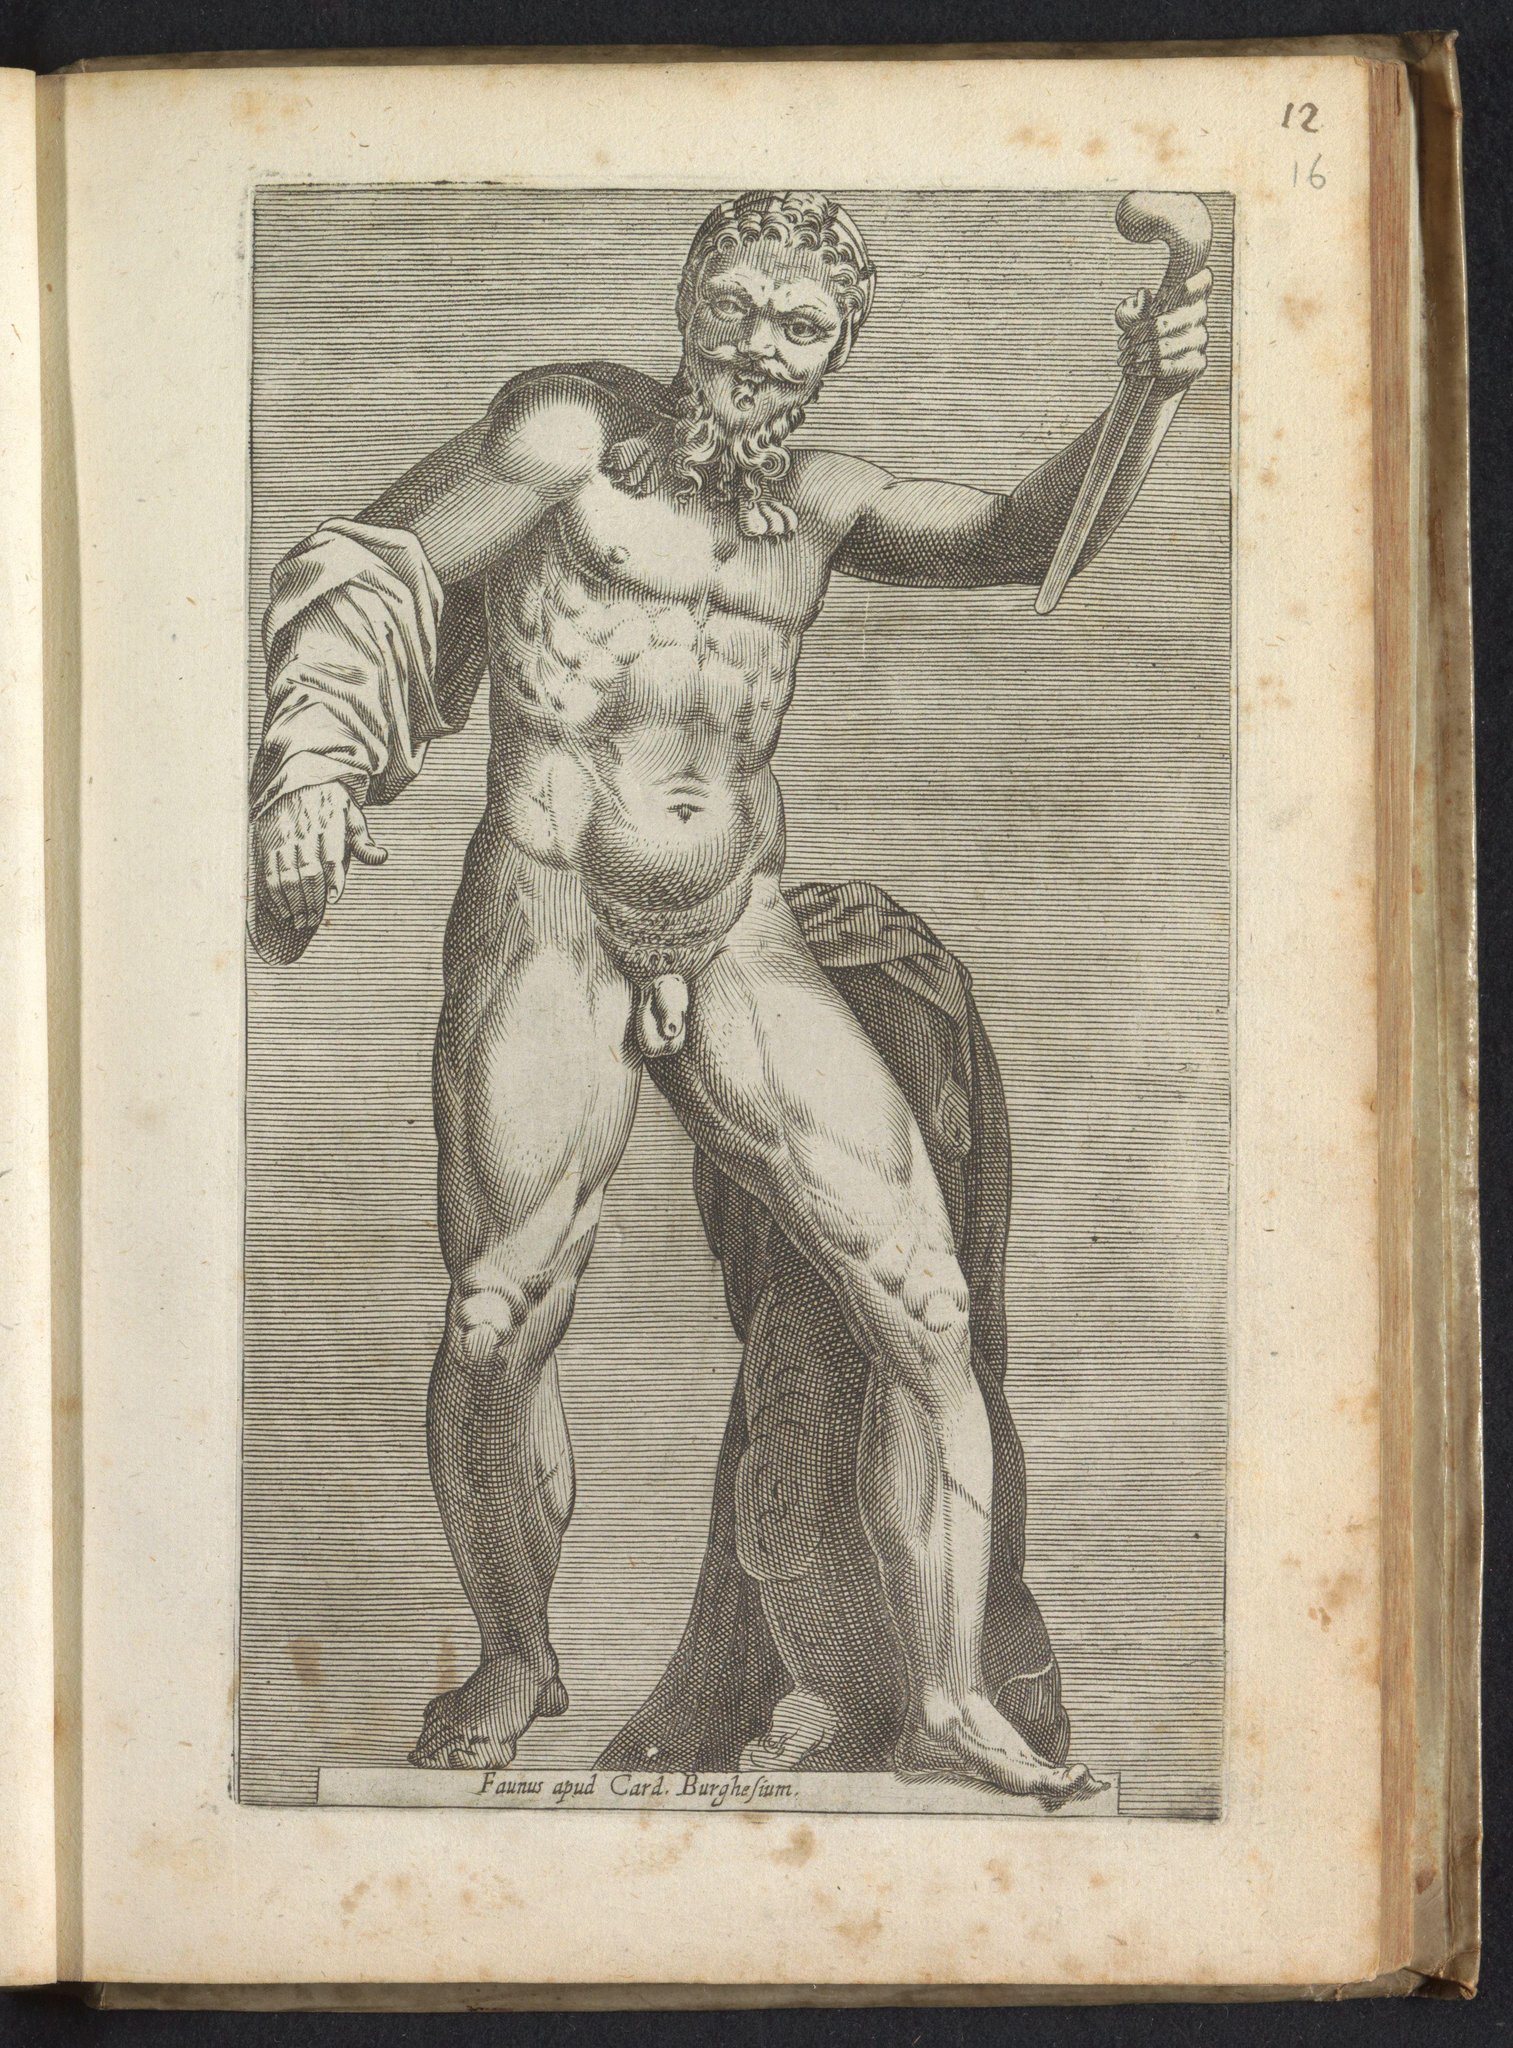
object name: print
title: Antiquarum statuarum urbis Romae quae in publicis locis visuntur icones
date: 1584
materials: paper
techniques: engraving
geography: italy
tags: satyrs, fauns, sileni, piece of sculpture, reproduction of a piece of sculpture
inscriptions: number: ‘12’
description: Deze prent maakt deel uit van een set van 79 prenten (+ titelprent) met voorstellingen van antieke sculpturen in Rome. Deze prent maakt deel uit van een set van 79 prenten (+ titelprent) met voorstellingen van antieke sculpturen in Rome.